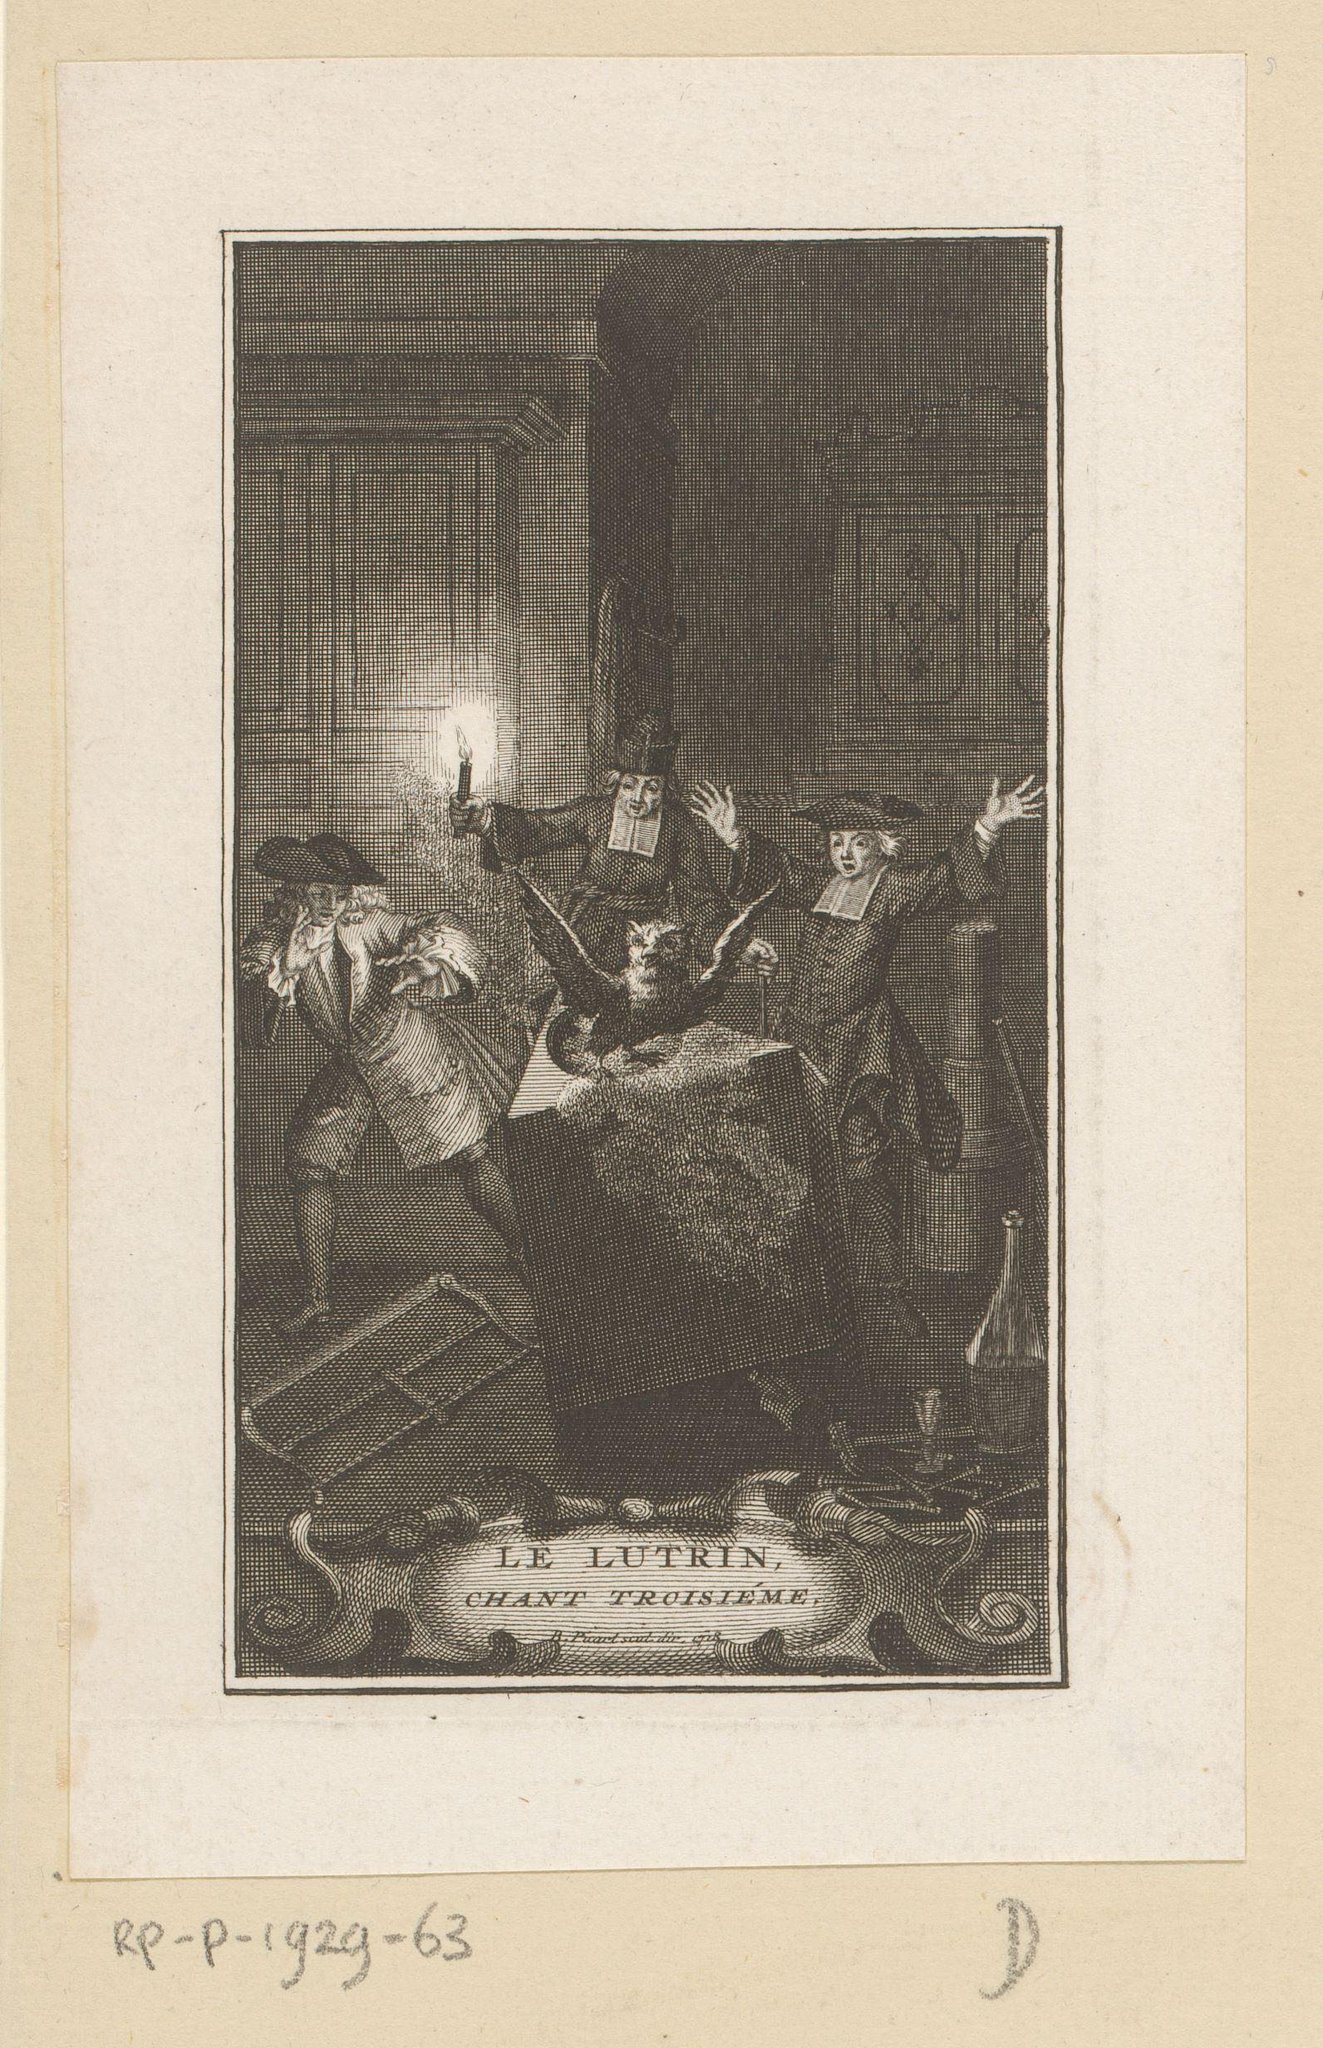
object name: print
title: Le Lutrin. Chant Troisiéme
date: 1718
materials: paper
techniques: engraving, etching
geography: amsterdam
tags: tools, implements of sculptor: mallet, owls, tools, aids, implements ~ crafts and industries: saw, night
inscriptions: collector's mark: Lugt 240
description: Deze prent is de kleine variant van een prent met hetzelfde onderwerp gebruikt in eerdere publicaties. Prent ook gebruikt in: Boileau, Nicolas. Oeuvres de Nicolas Boileau Despréaux. Den Haag: Isaac Vaillant, Pierre Gosse en Pieter de Hondt, 1722, dl. 2.